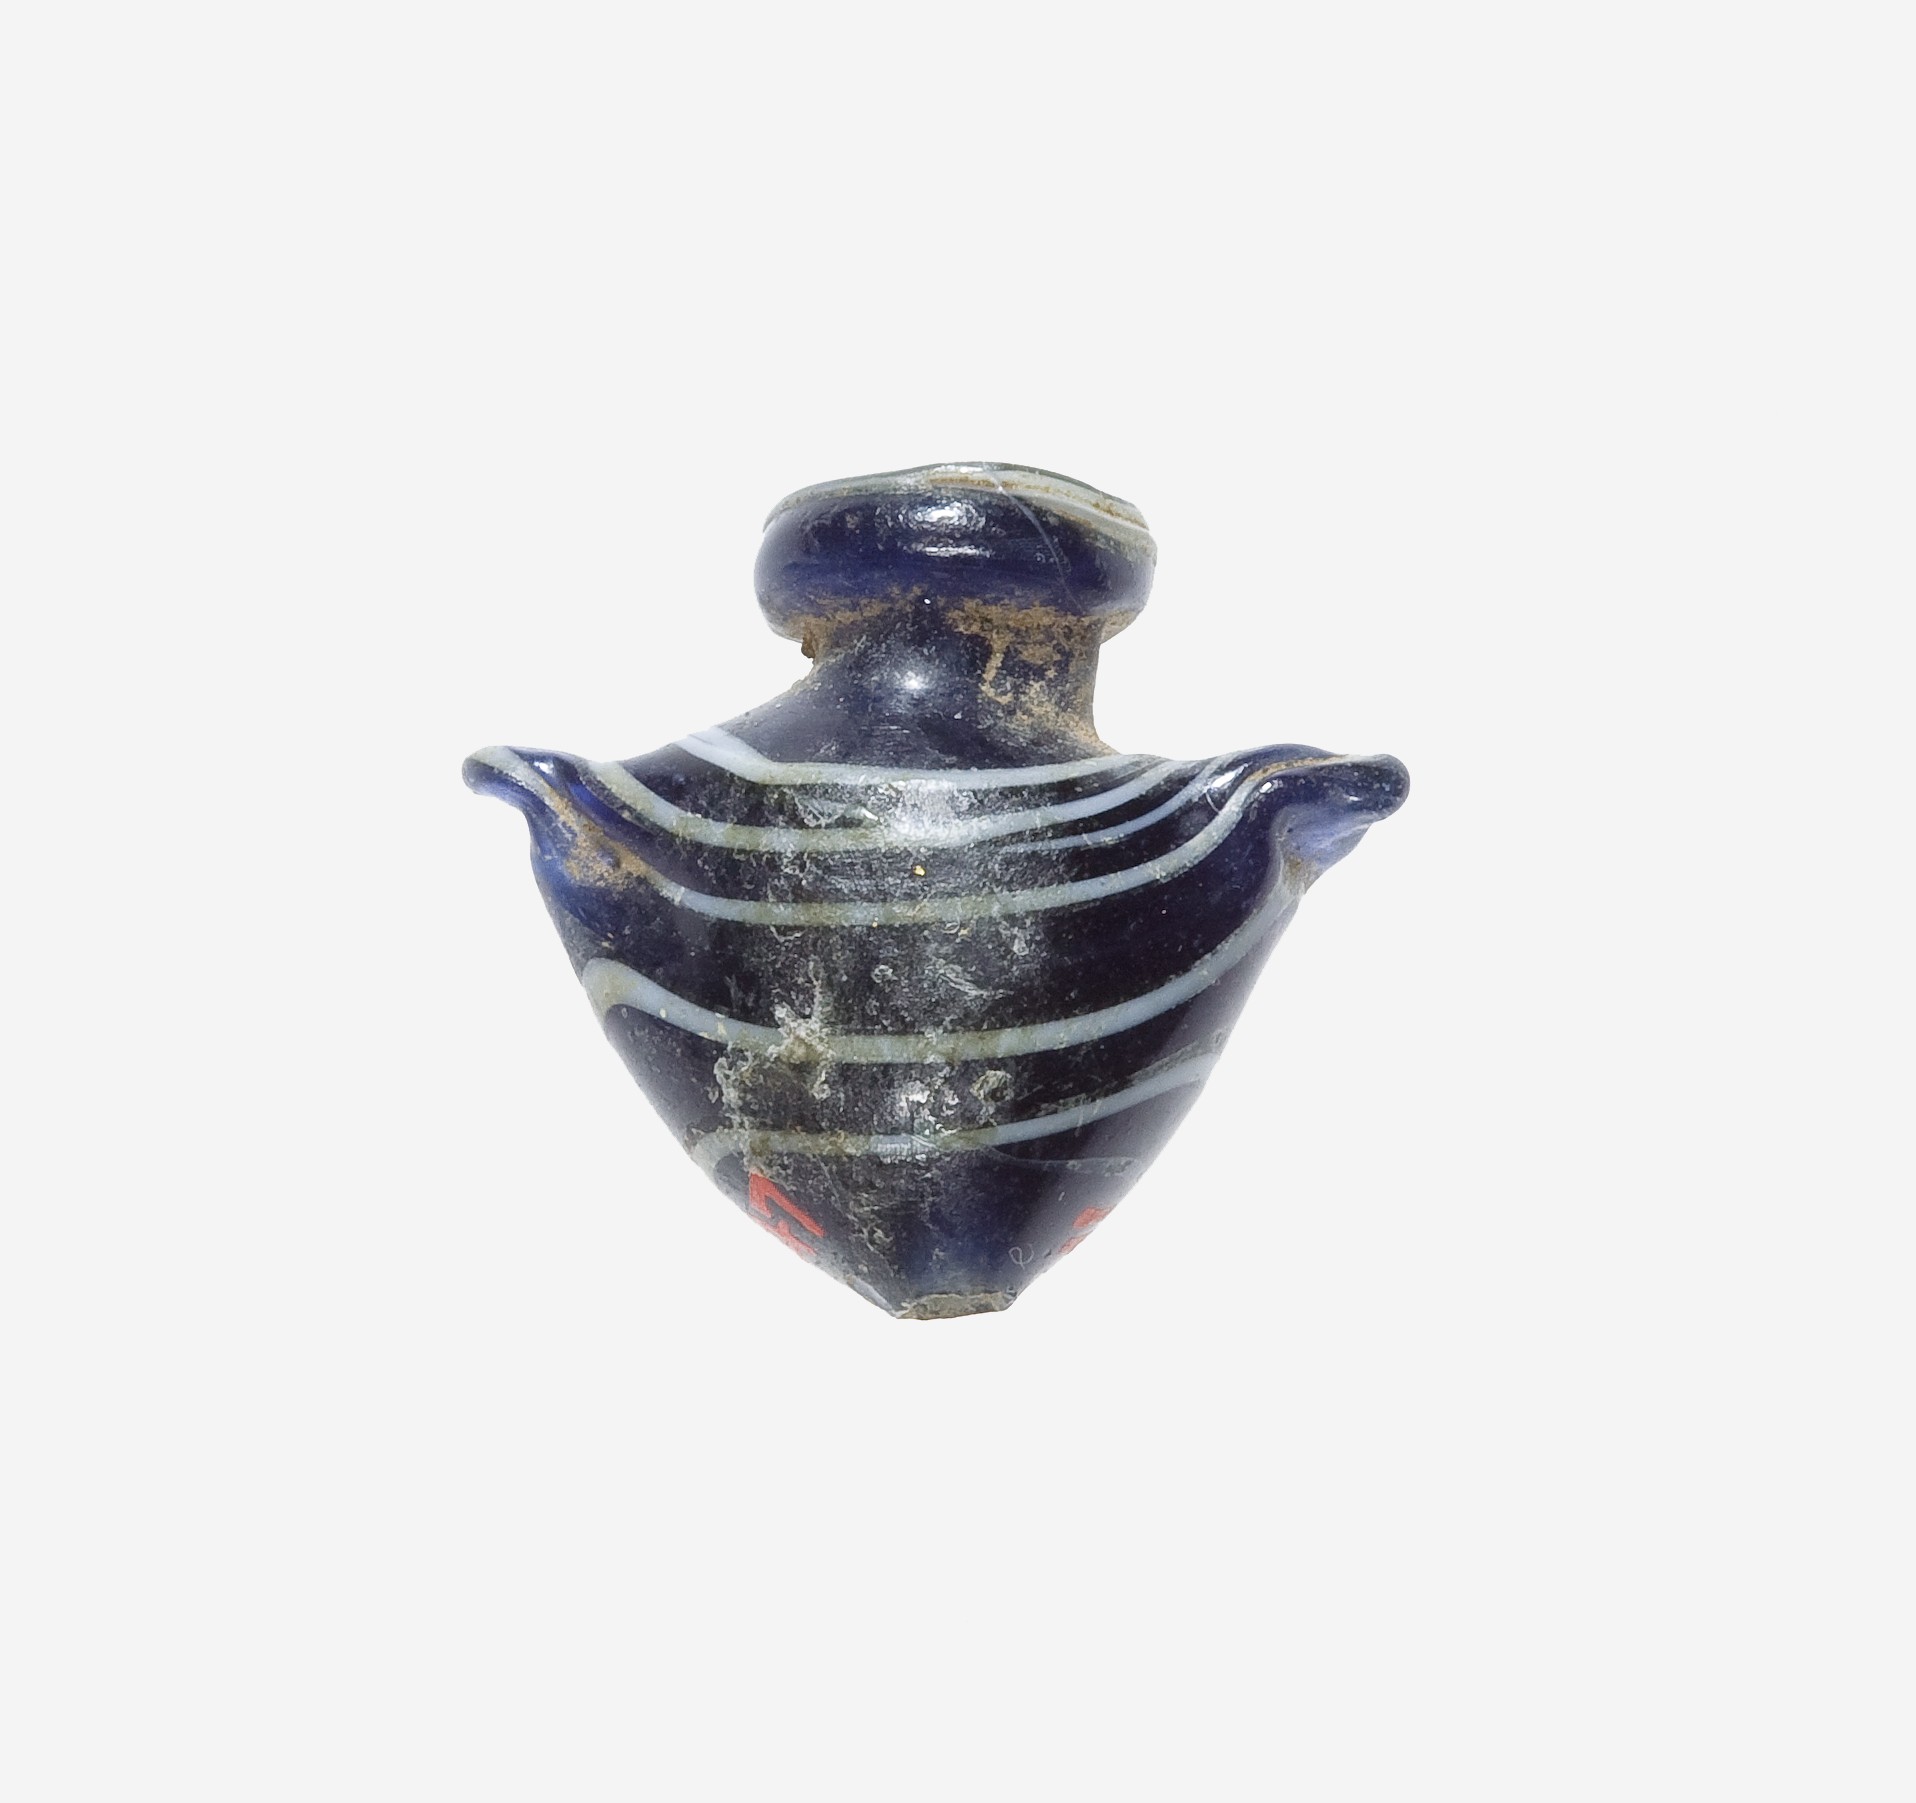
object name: amulet, heart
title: Heart Amulet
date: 1390-1352 BCE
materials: glass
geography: egypt